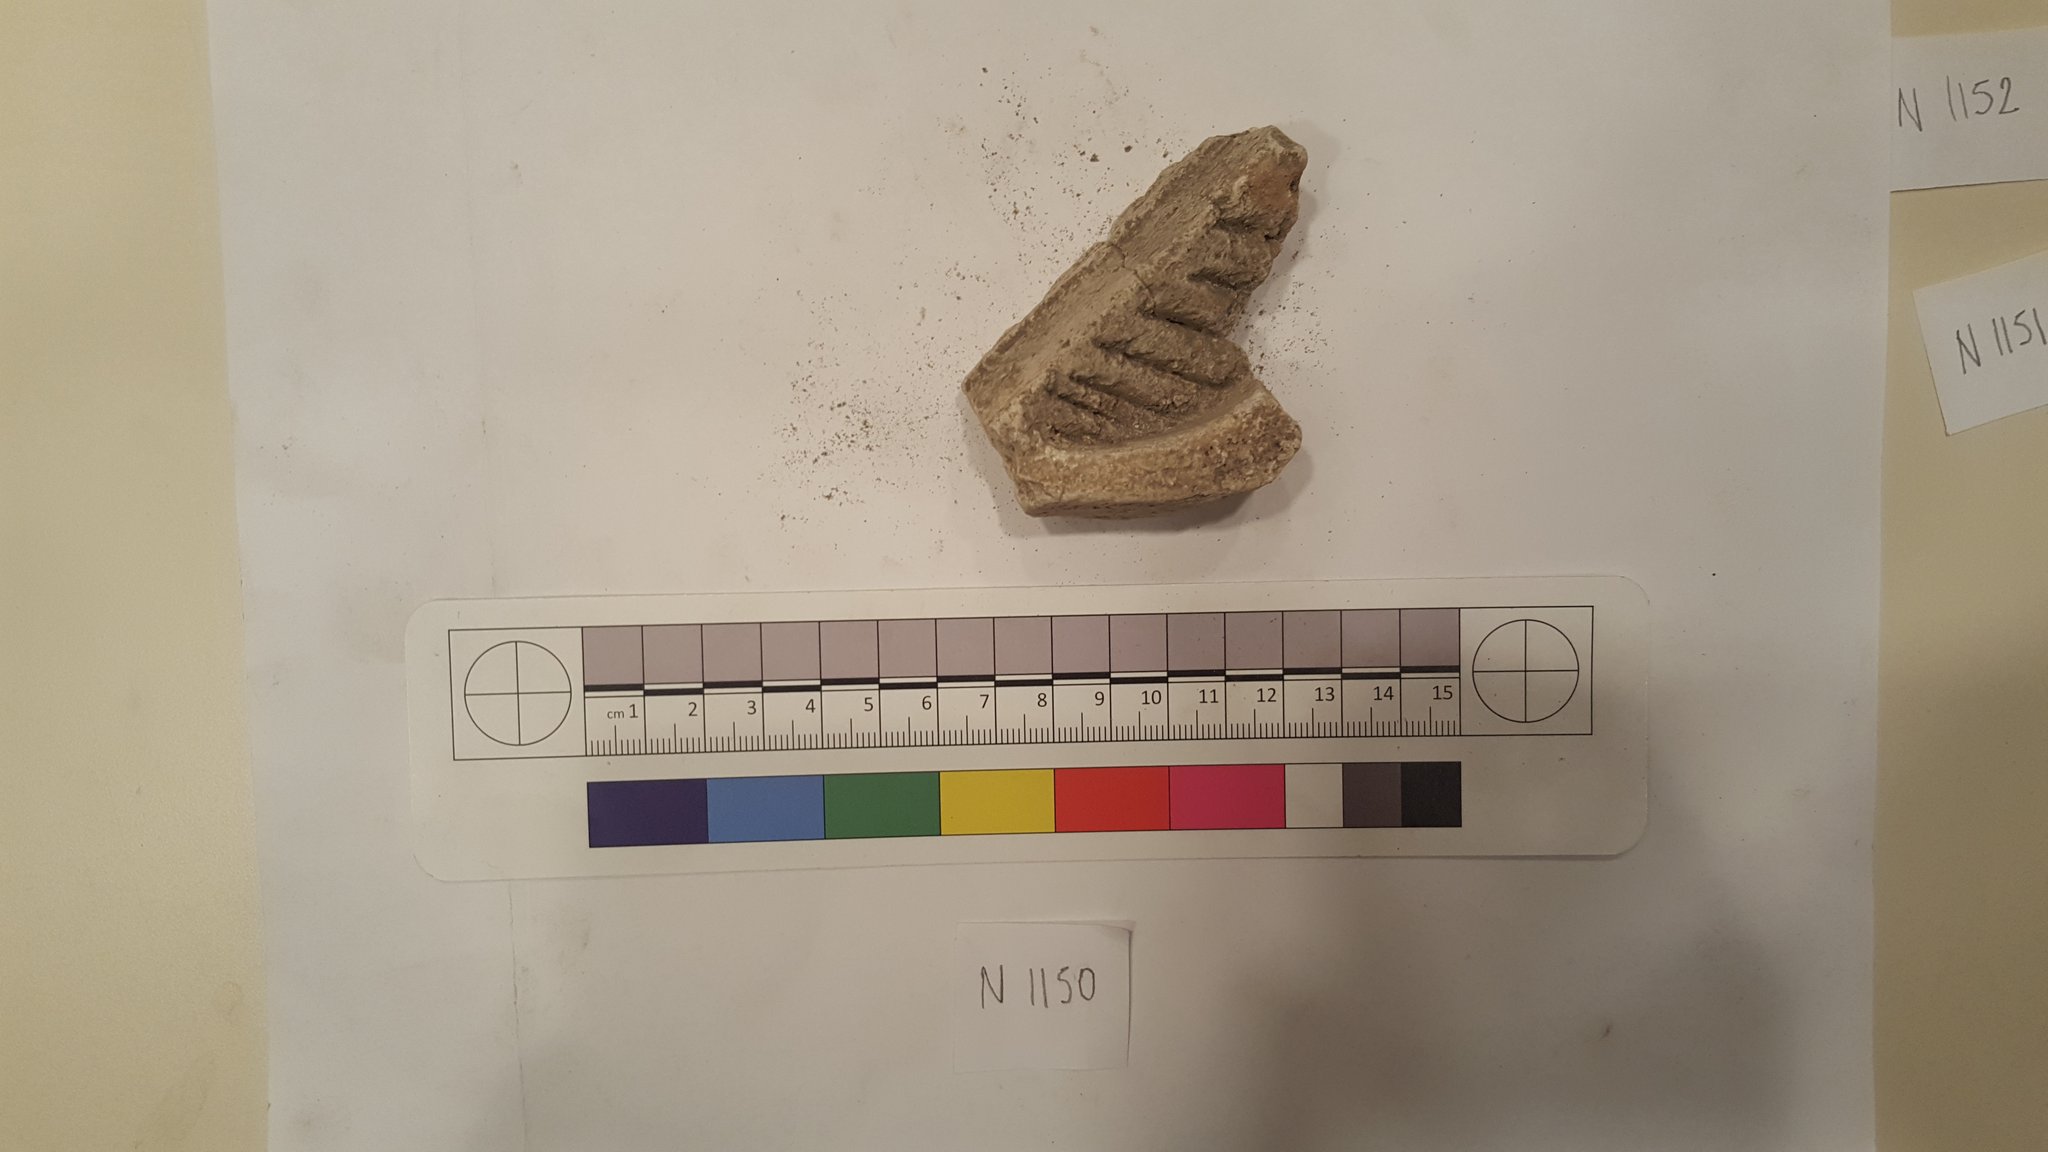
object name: fragment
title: Stucco Fragment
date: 701-1200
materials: plaster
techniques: carving, painting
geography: iran